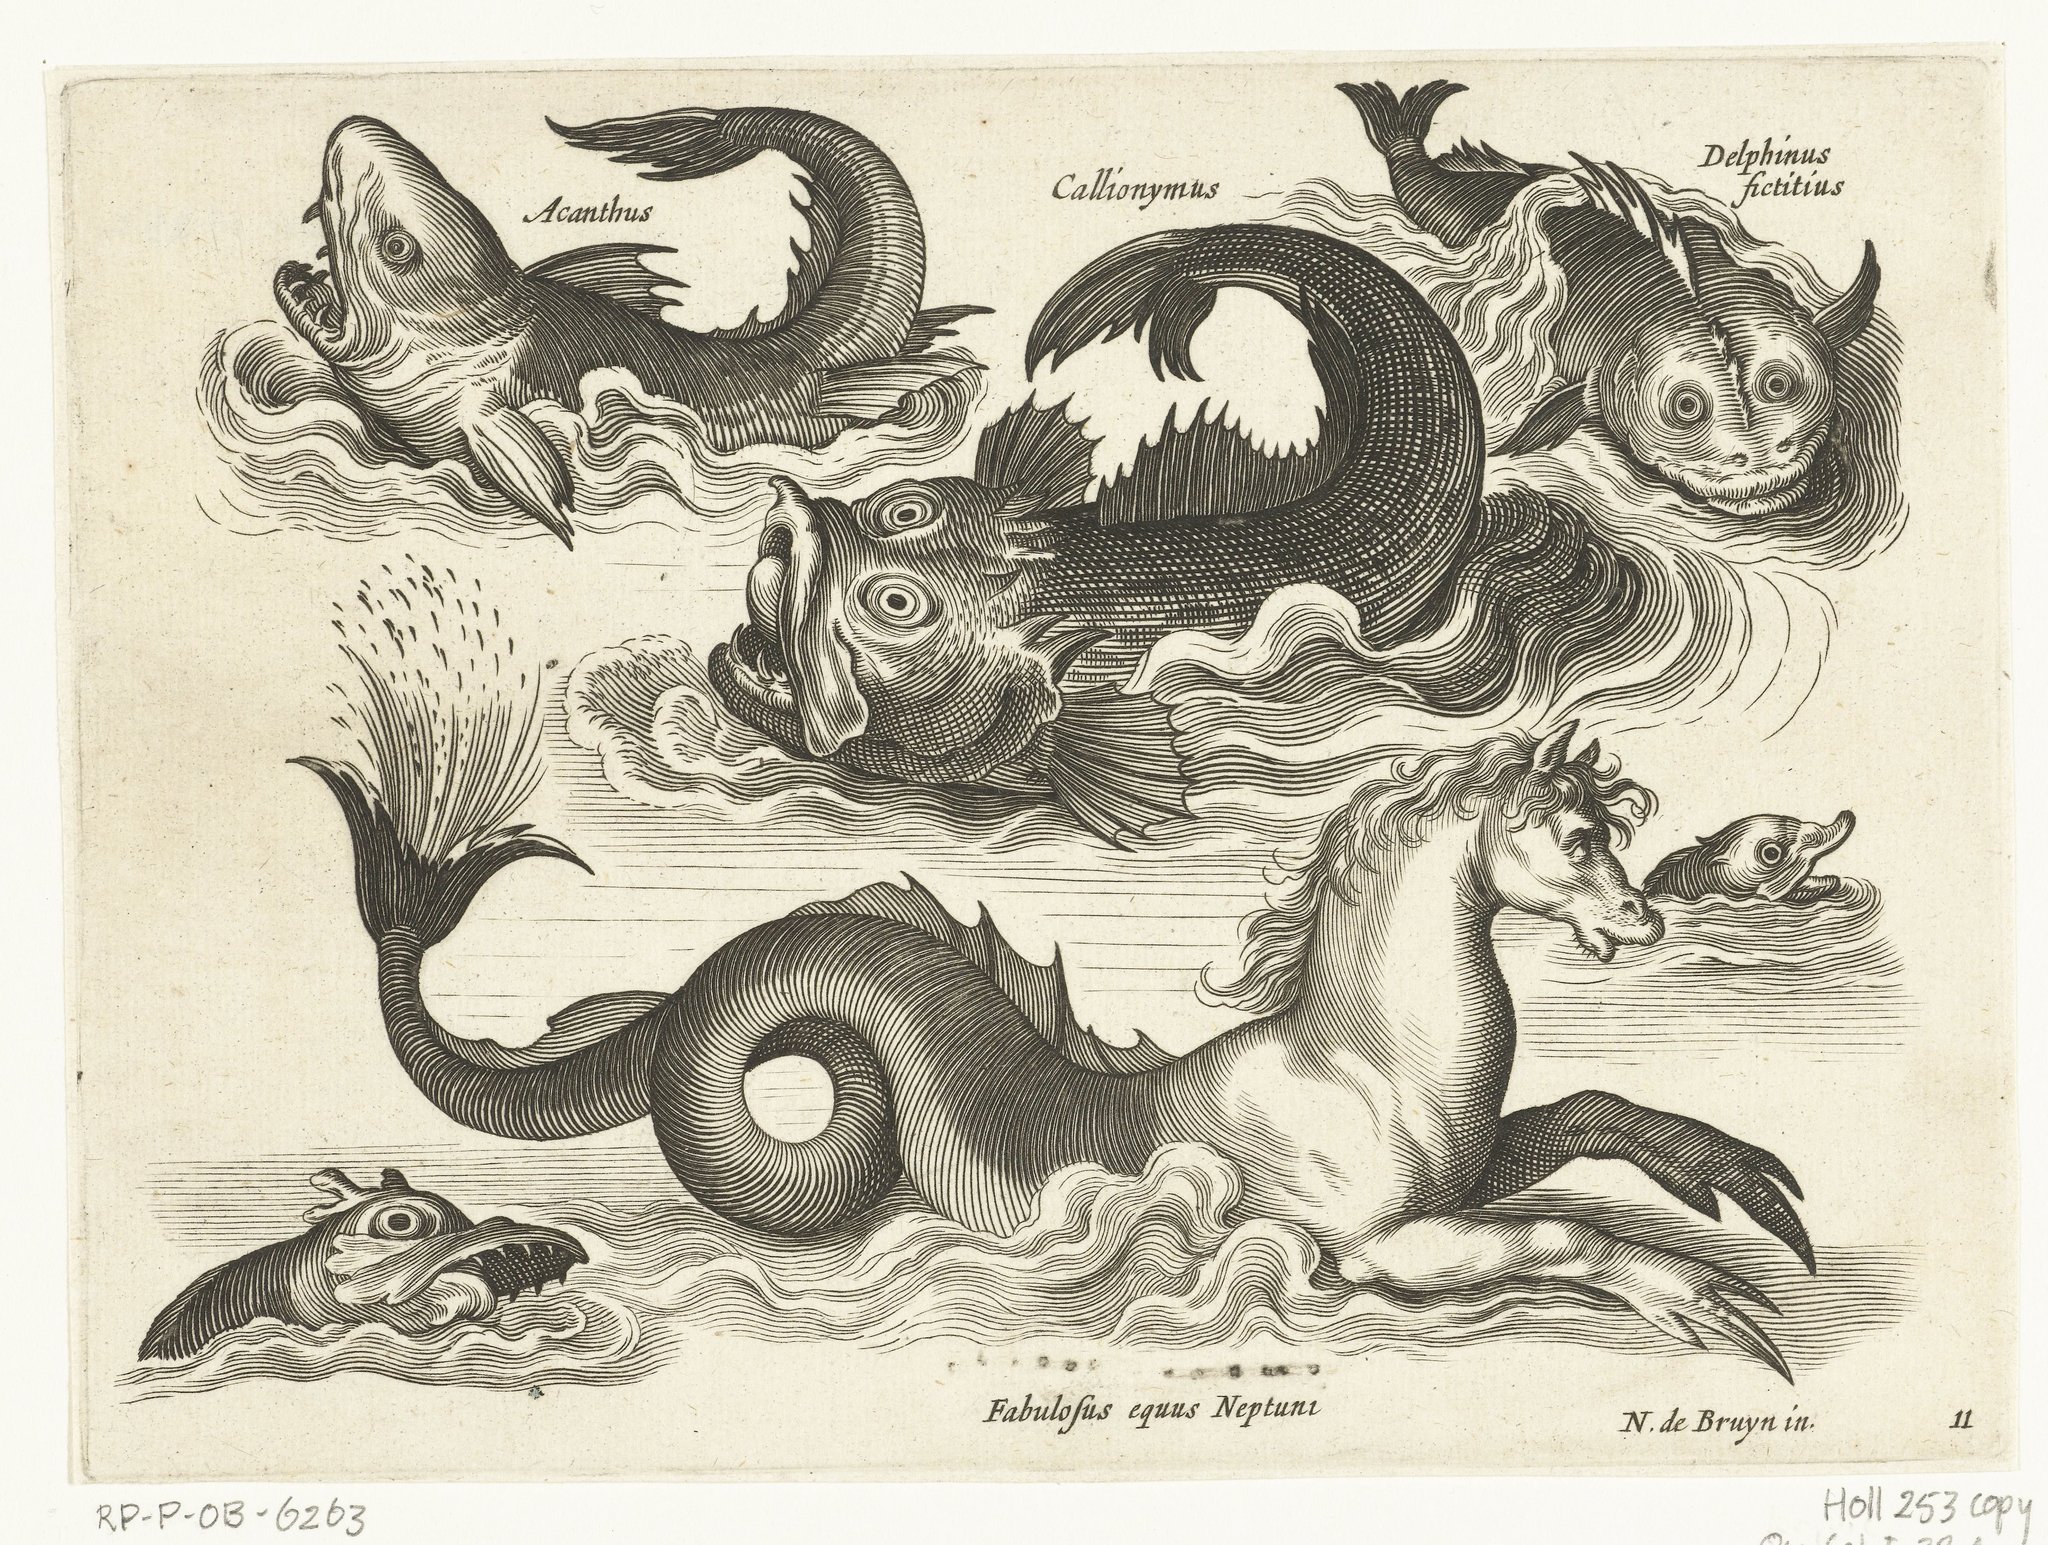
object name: print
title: Fantastische waterdieren, onder andere zeepaard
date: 1581-1652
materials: paper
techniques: engraving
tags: sea-horse, hippocamp, 'hippocampus', (horse/fish) (mythological hybrid monster), fabulous animals ~ fishes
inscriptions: collector's mark: Lugt 2228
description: Kopie naar prent van Nicolaes de Bruyn uit serie Libelivs varia Genera piscium complectens van dertien prenten met zoetwatervissen, zeevissen, kikkers, schaaldieren en zeewezens (inclusief titelprent).